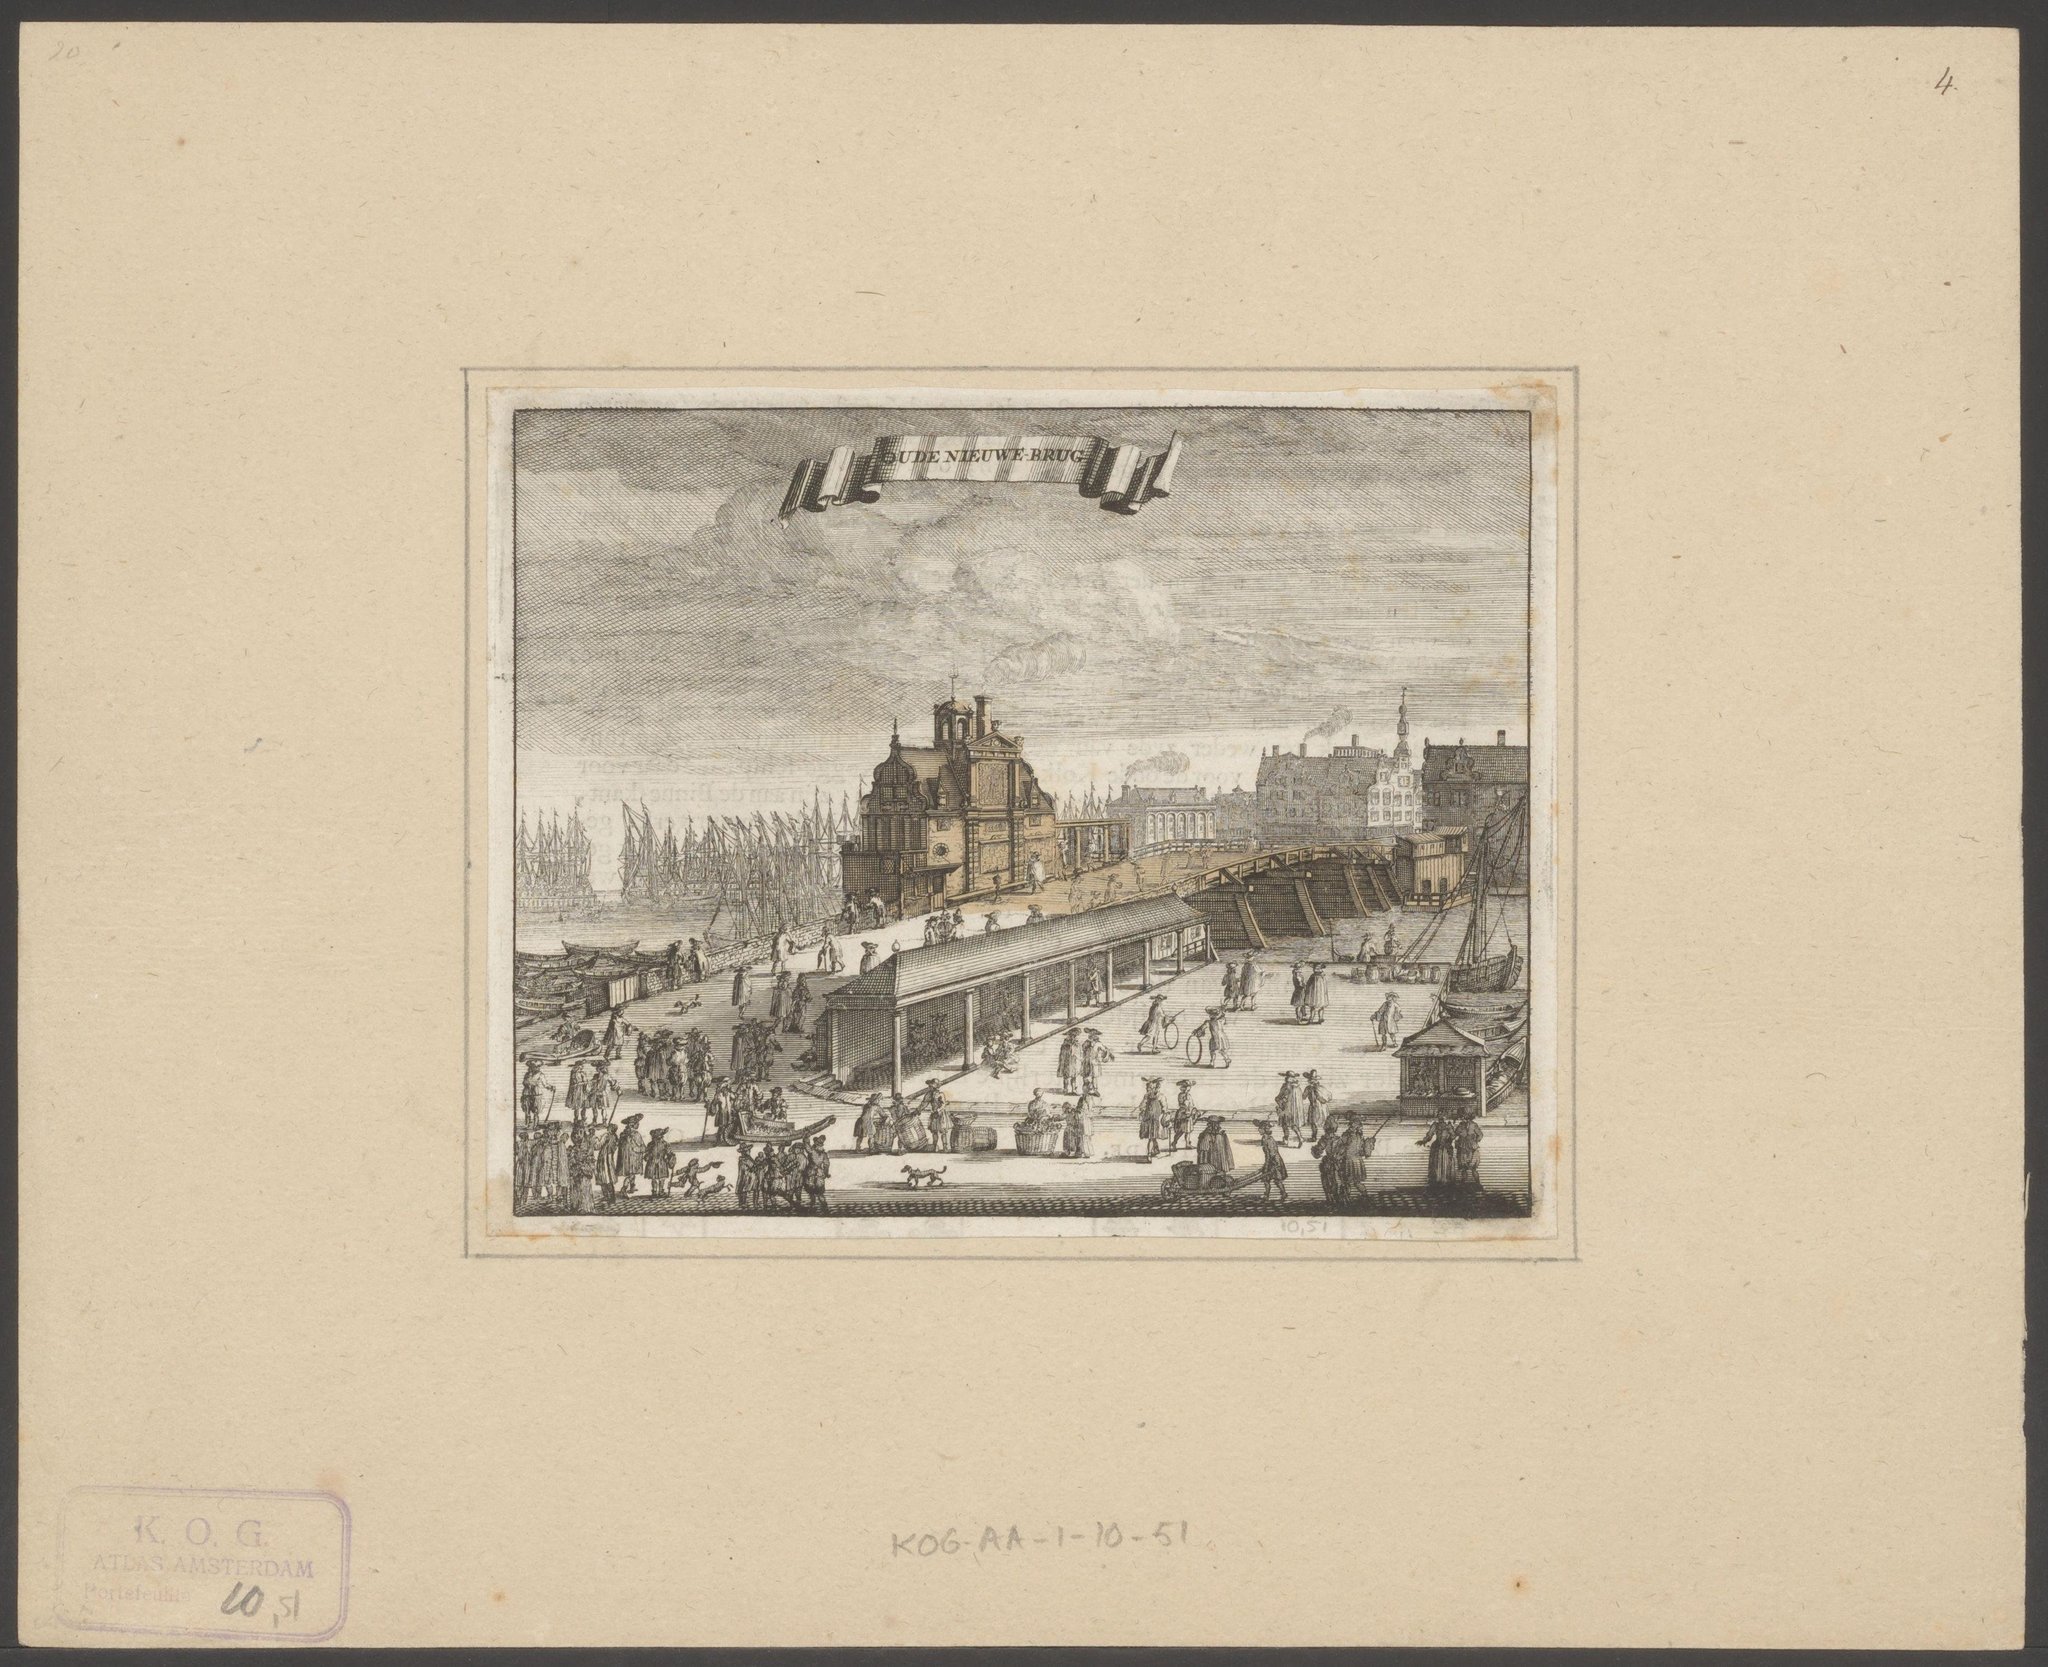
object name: book illustration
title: Oude Nieuwe-Brug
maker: Anonymous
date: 1726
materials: paper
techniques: engraving, etching, hand coloring, letterpress printing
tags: city-view in general; 'veduta', canal, bridge in city across river, canal, etc., taxes and financial administration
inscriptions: collector's mark: ‘10,51’ Lugt 1641b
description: Prent uit: Commelin, Caspar. Beschryvinge van Amsterdam, zynde een naukeurige verhandelinge van desselfs eerste oorspronk uyt (…). 2 delen. 2e druk. Amsterdam: Andries van Damme, Johannes Ratelband, weduwe A. van Aaltwyk en Hermanus Uytwerf, 1726.